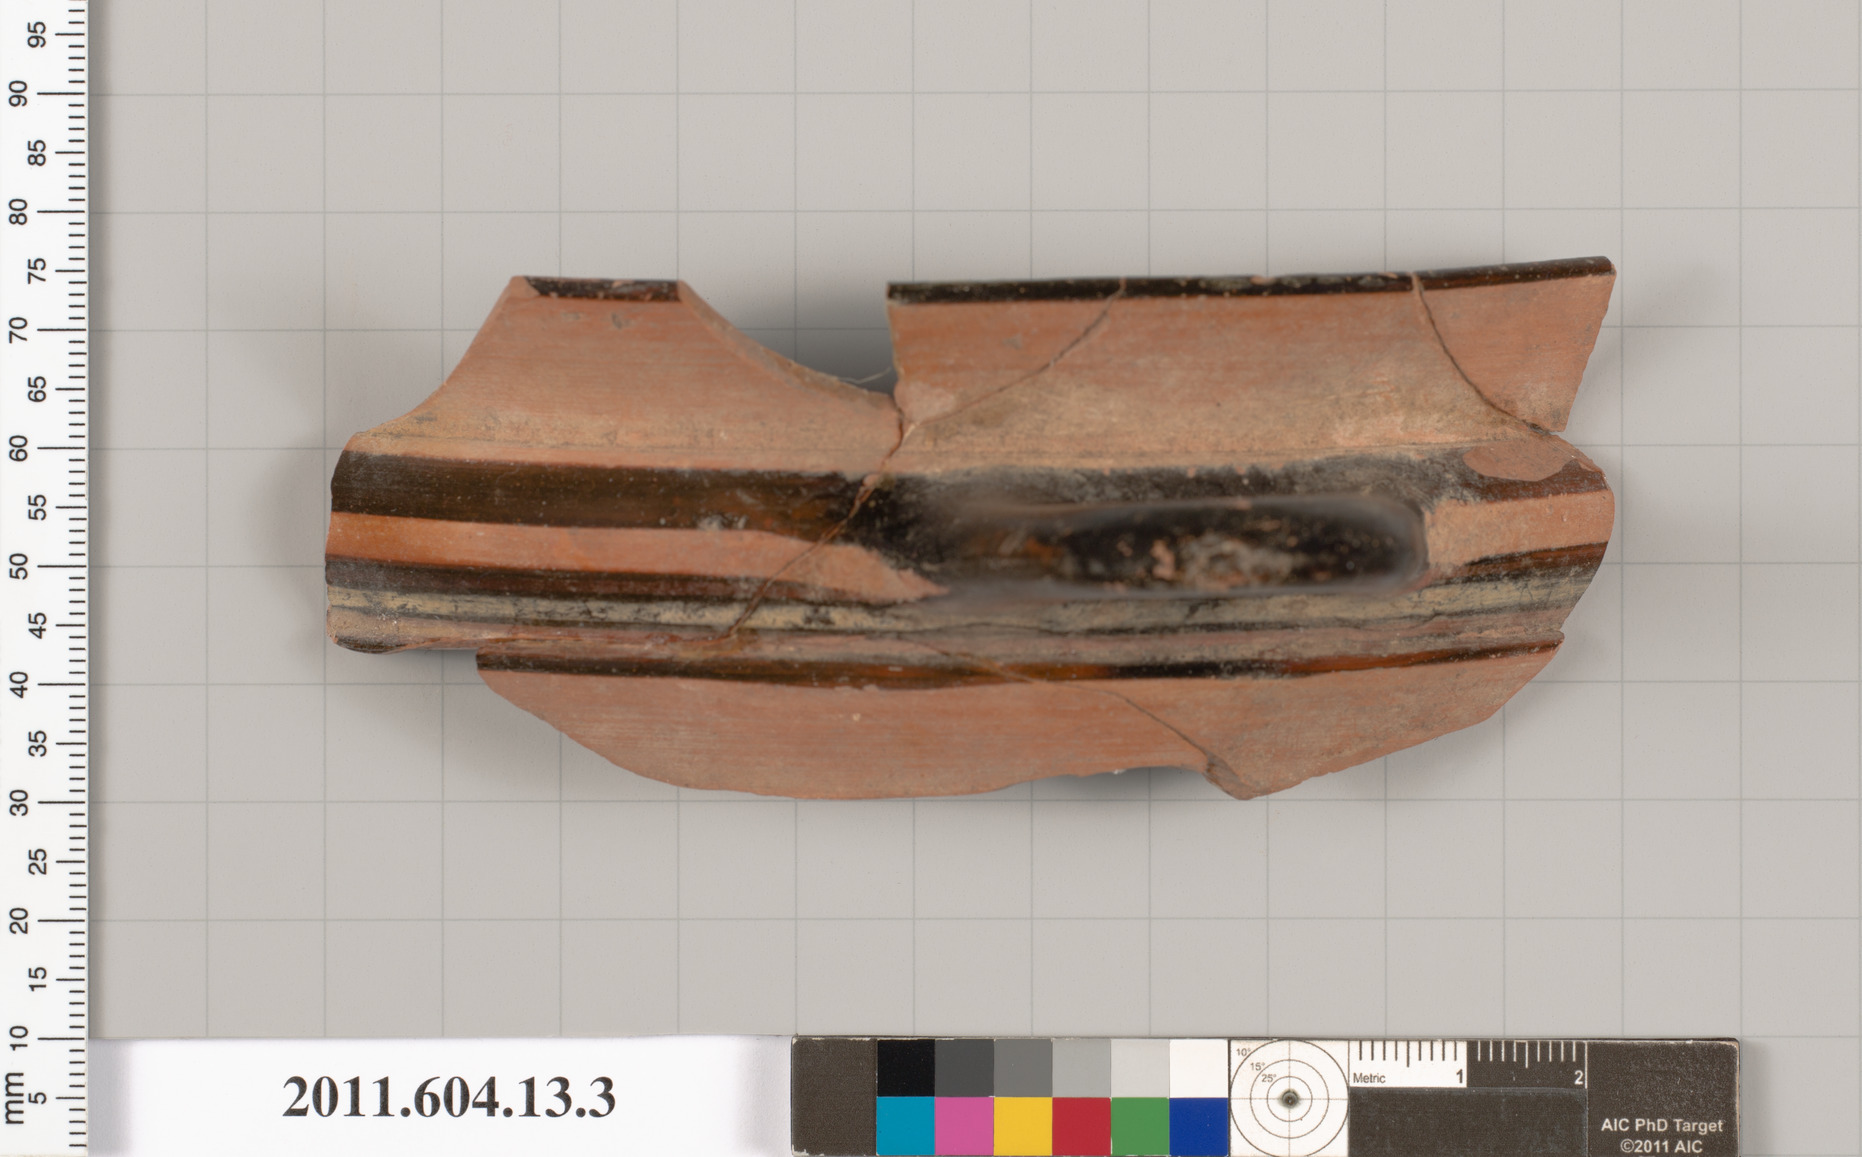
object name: kylix fragment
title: Terracotta fragment of a kylix (drinking cup)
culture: east greek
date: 600-568 BCE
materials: terracotta